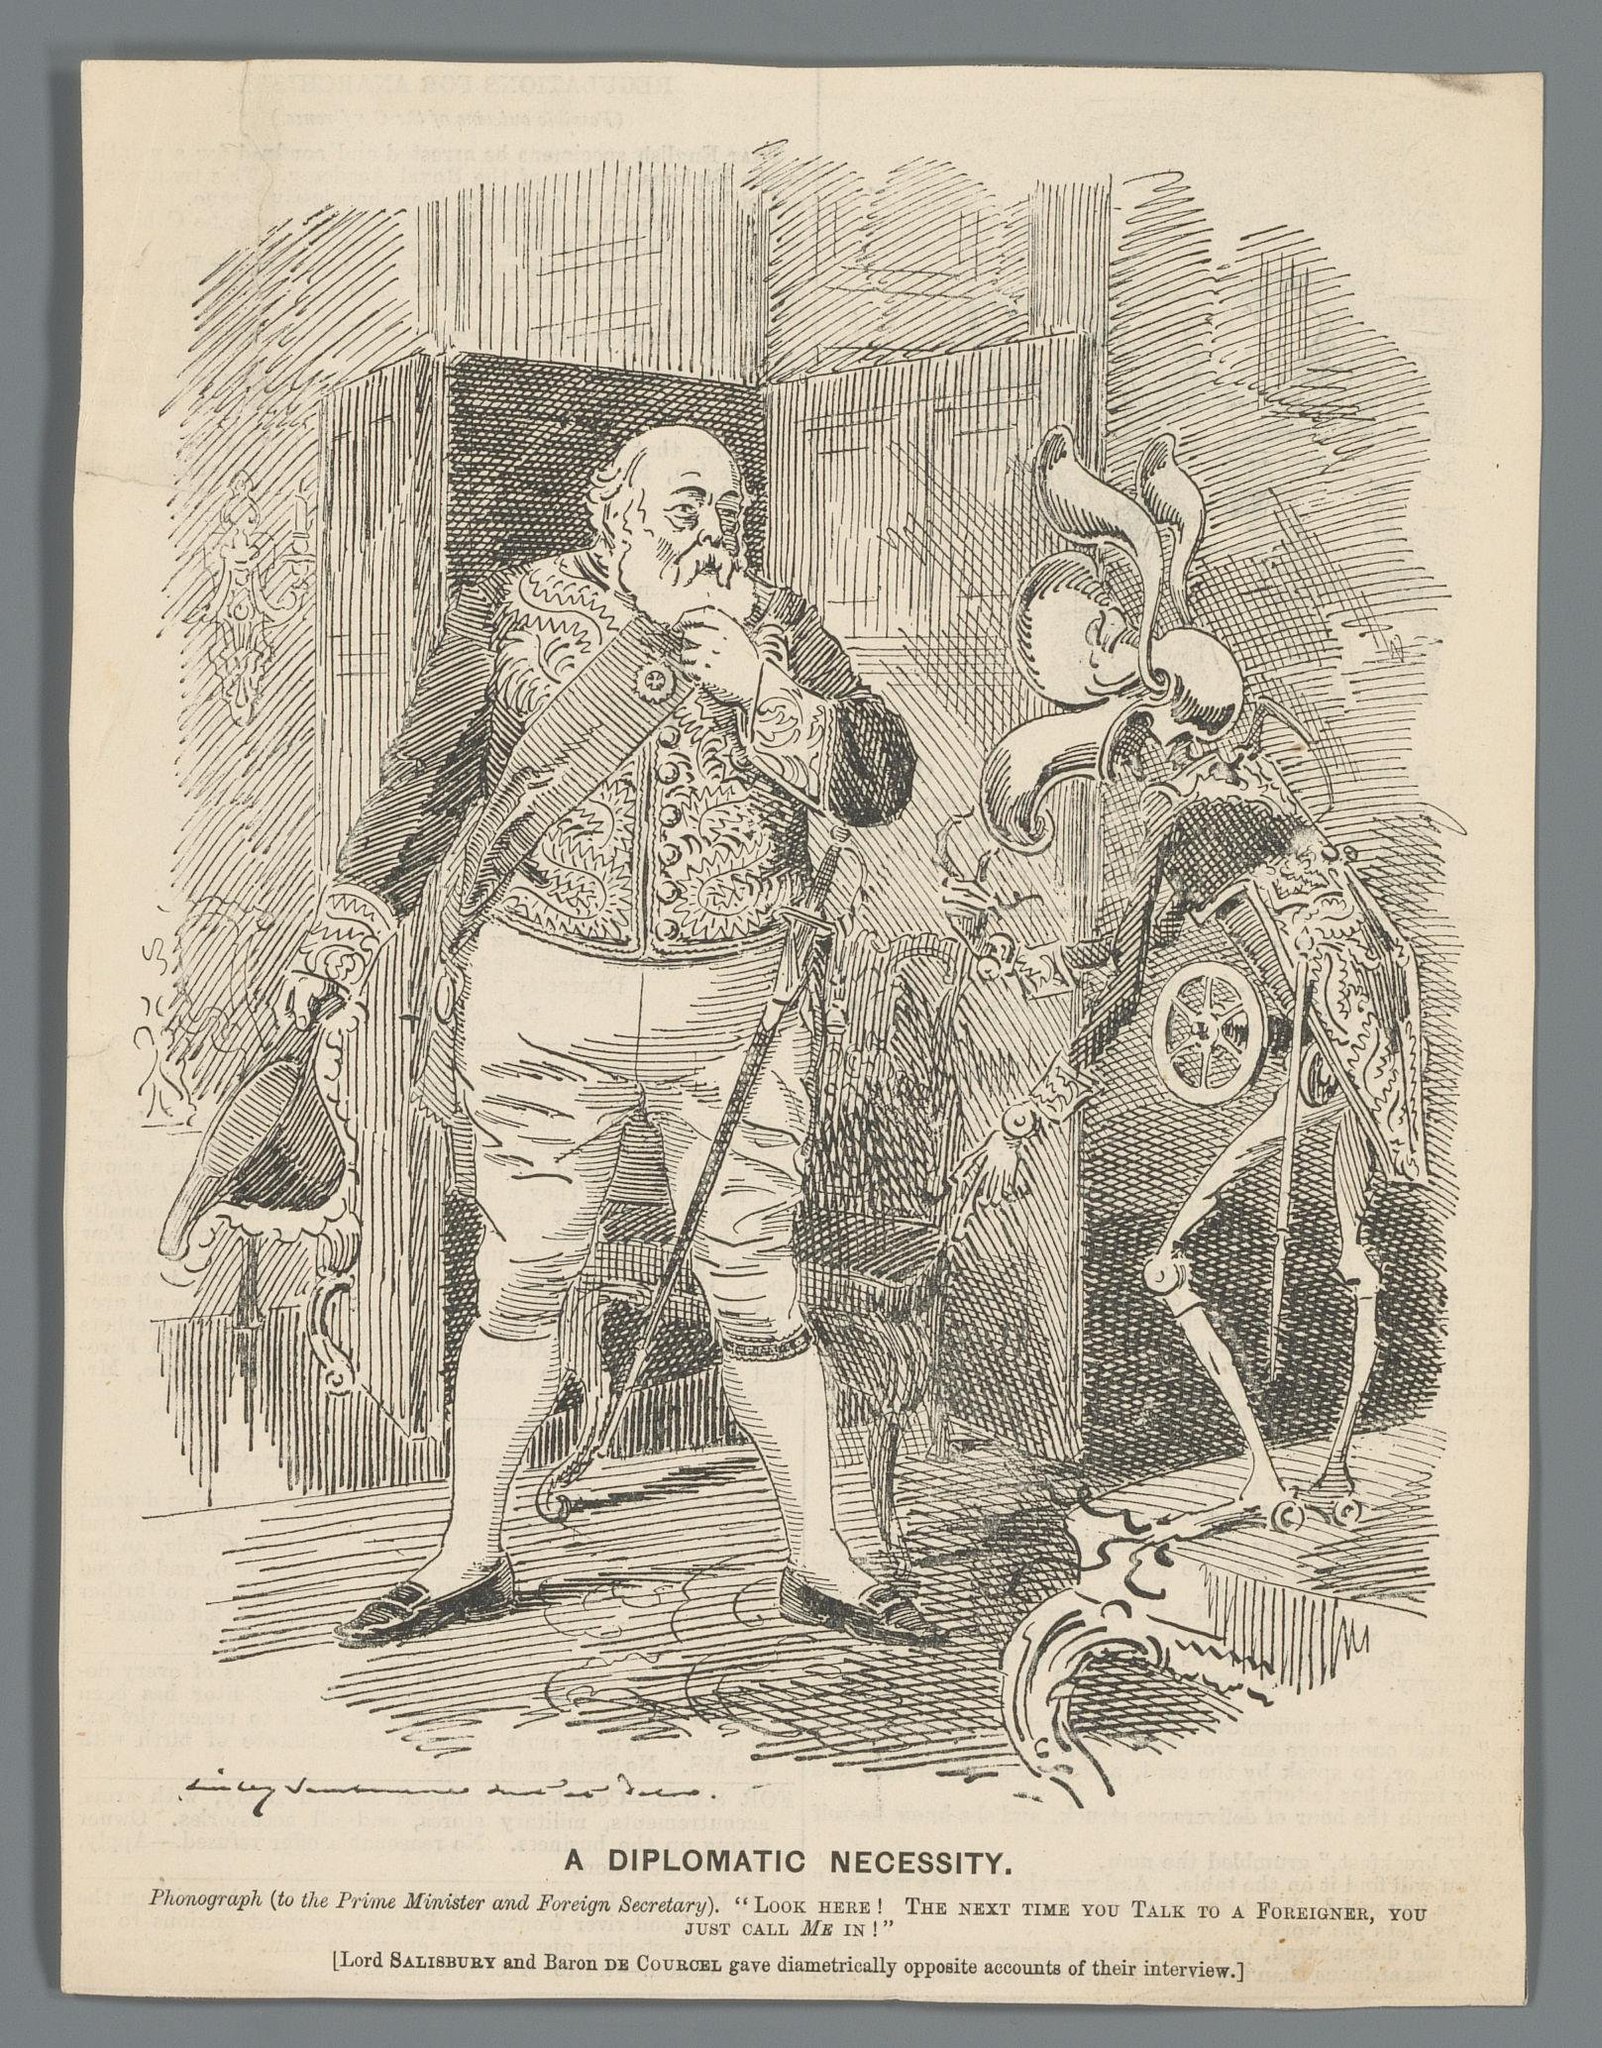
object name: print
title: Premier Gascoyne-Cecil aangesproken door een fonograaf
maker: edward linley sambourne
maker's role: draughtsman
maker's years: 1844-1910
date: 1895-1902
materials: paper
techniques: line block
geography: england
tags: politician, phonograph, gramophone; playing recorded sound or video, political caricatures and satires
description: Premier Gascoyne-Cecil aangesproken door de personificatie van een fonograaf. Spotprent uit het satirische tijdschrift Punch, ca. 1895-1902.